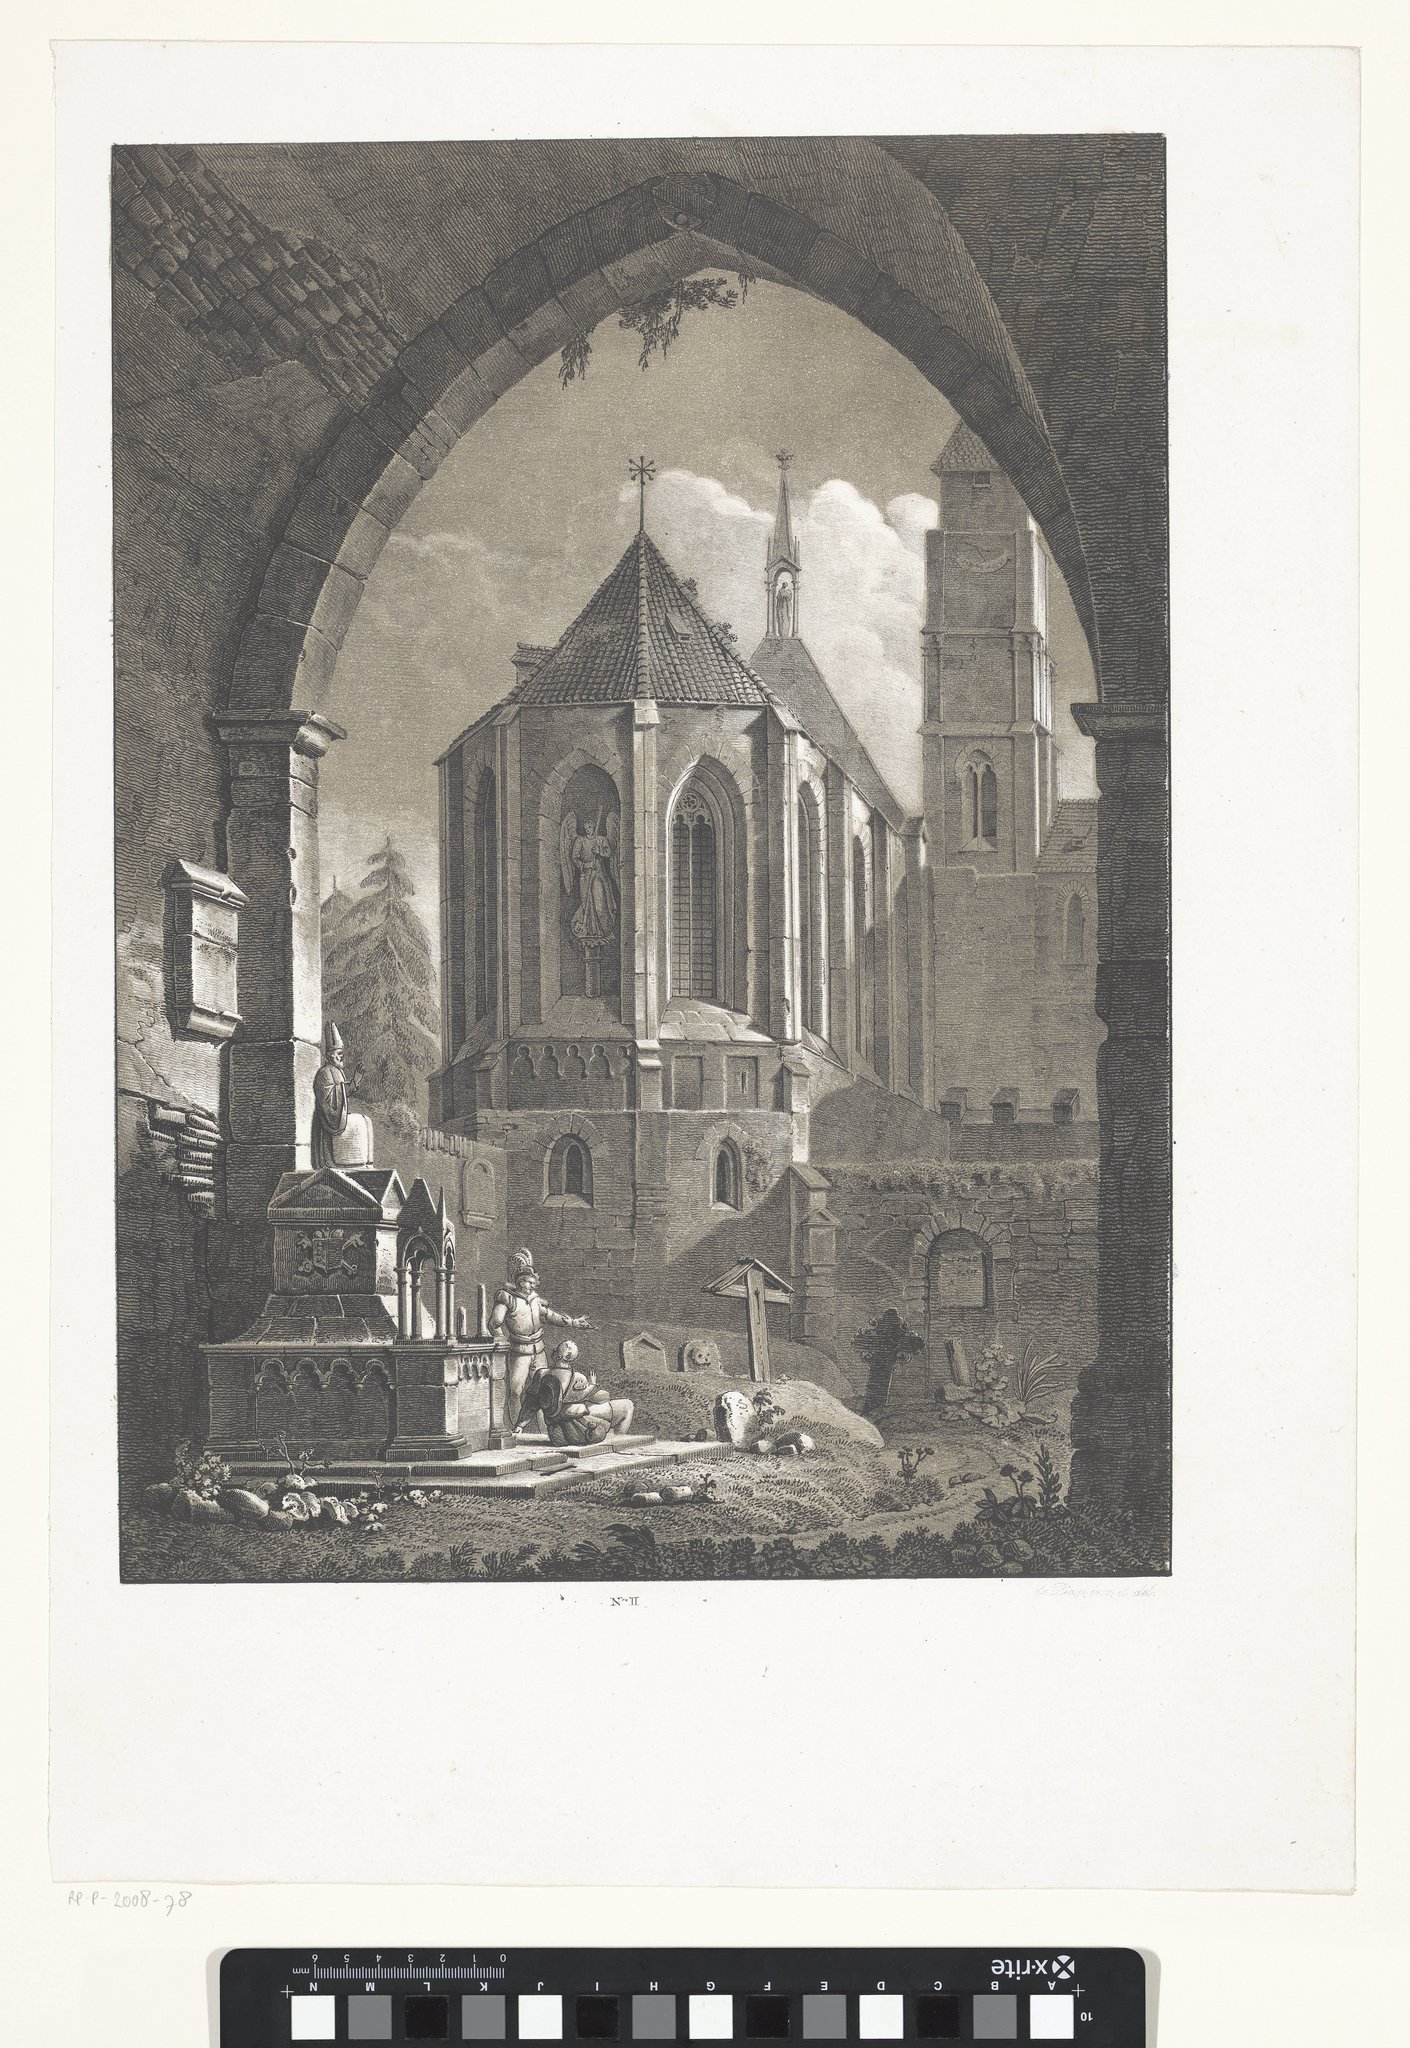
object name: print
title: Soldaten bij grafmonument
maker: antonio de pian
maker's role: painter, print maker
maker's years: 1784-1851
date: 1794-1851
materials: paper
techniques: lithograph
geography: italy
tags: church (exterior), grave, tomb, the soldier; the soldier's life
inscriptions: collector's mark: Lugt 2760, collector's mark: Lugt 2228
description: Twee soldaten bij een grafmonument onder een boog achter een gotische kerk. Genummerd midden onder: No. II.